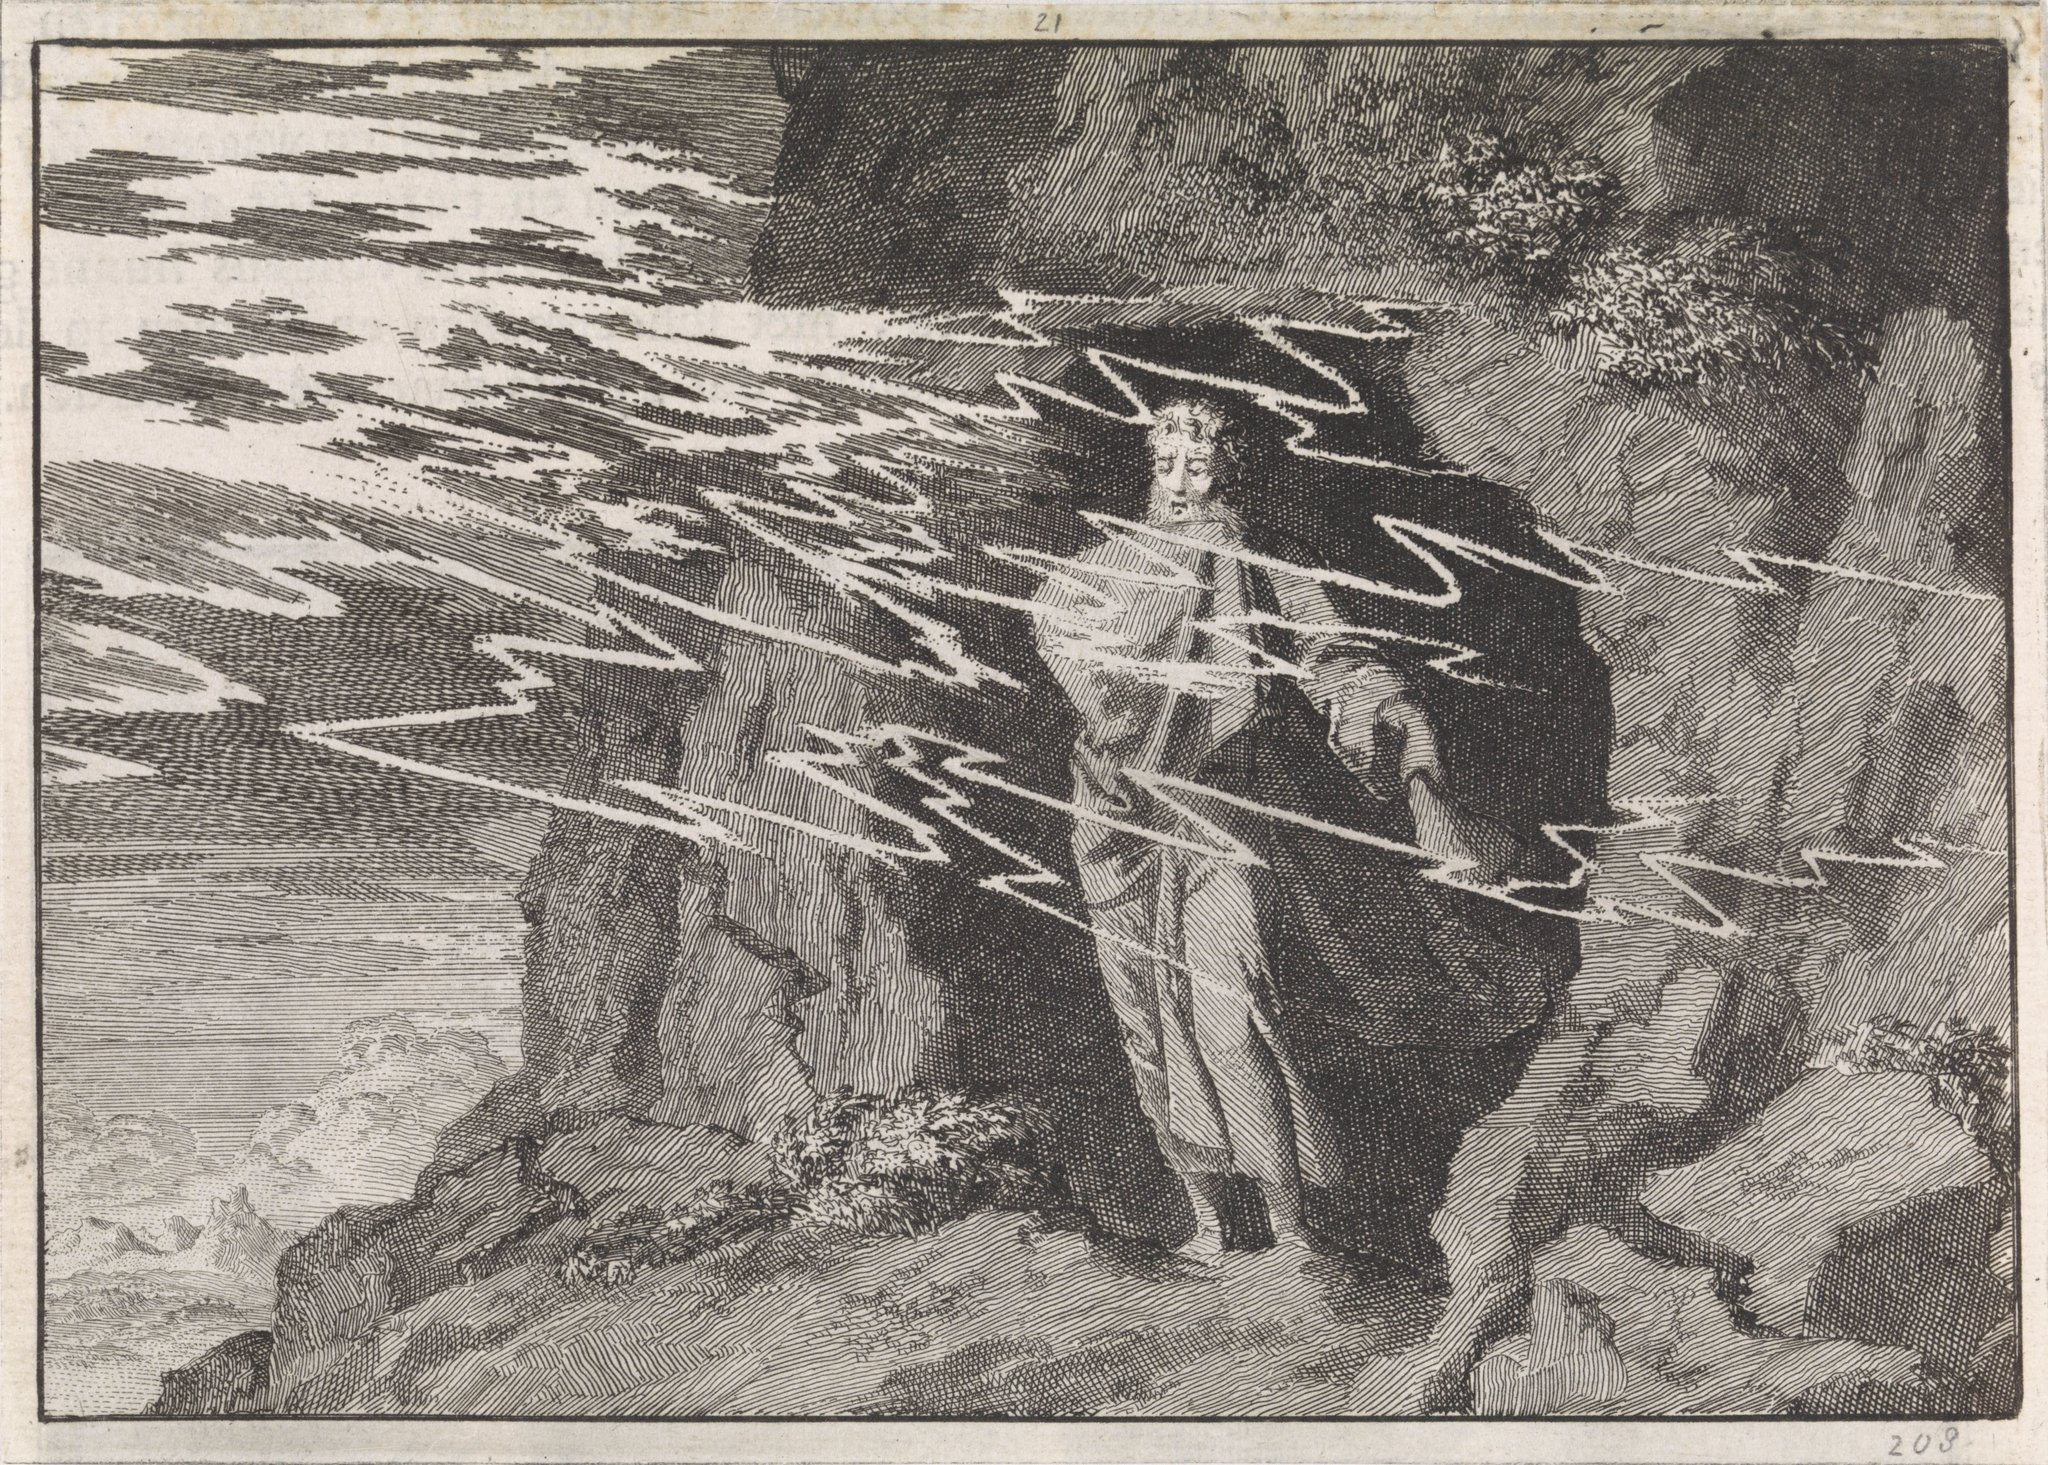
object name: book illustration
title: Elia in de grot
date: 1704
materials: paper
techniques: etching, letterpress printing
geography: amsterdam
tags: elijah comes to mount horeb where he dwells in a cave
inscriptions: collector's mark: Lugt 2228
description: Prent opgenomen in: Josephus, Flavius. Alle de Werken, 2 delen. Amsterdam: Pieter Mortier, 1704, dl. 1, p. 208.